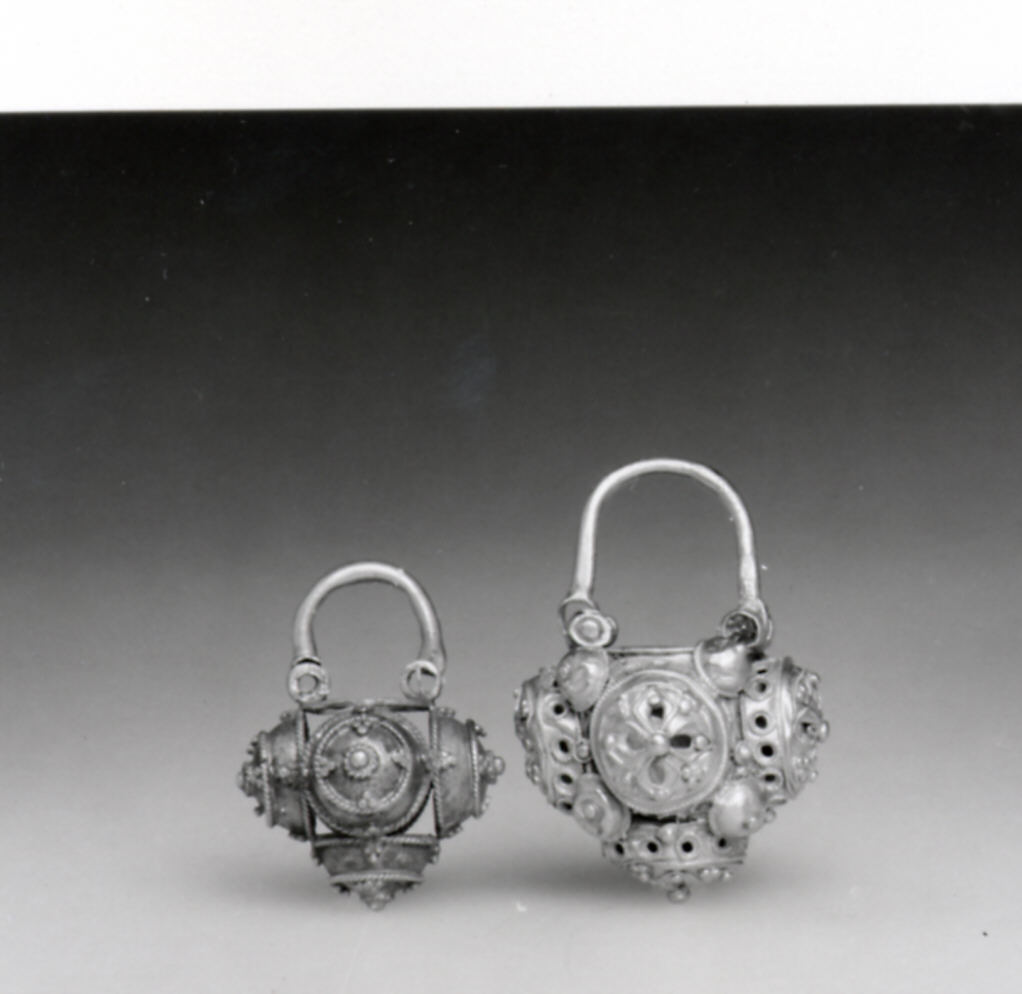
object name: earring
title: Basket Earring, One of a Pair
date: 1001-1300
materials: gold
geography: iran